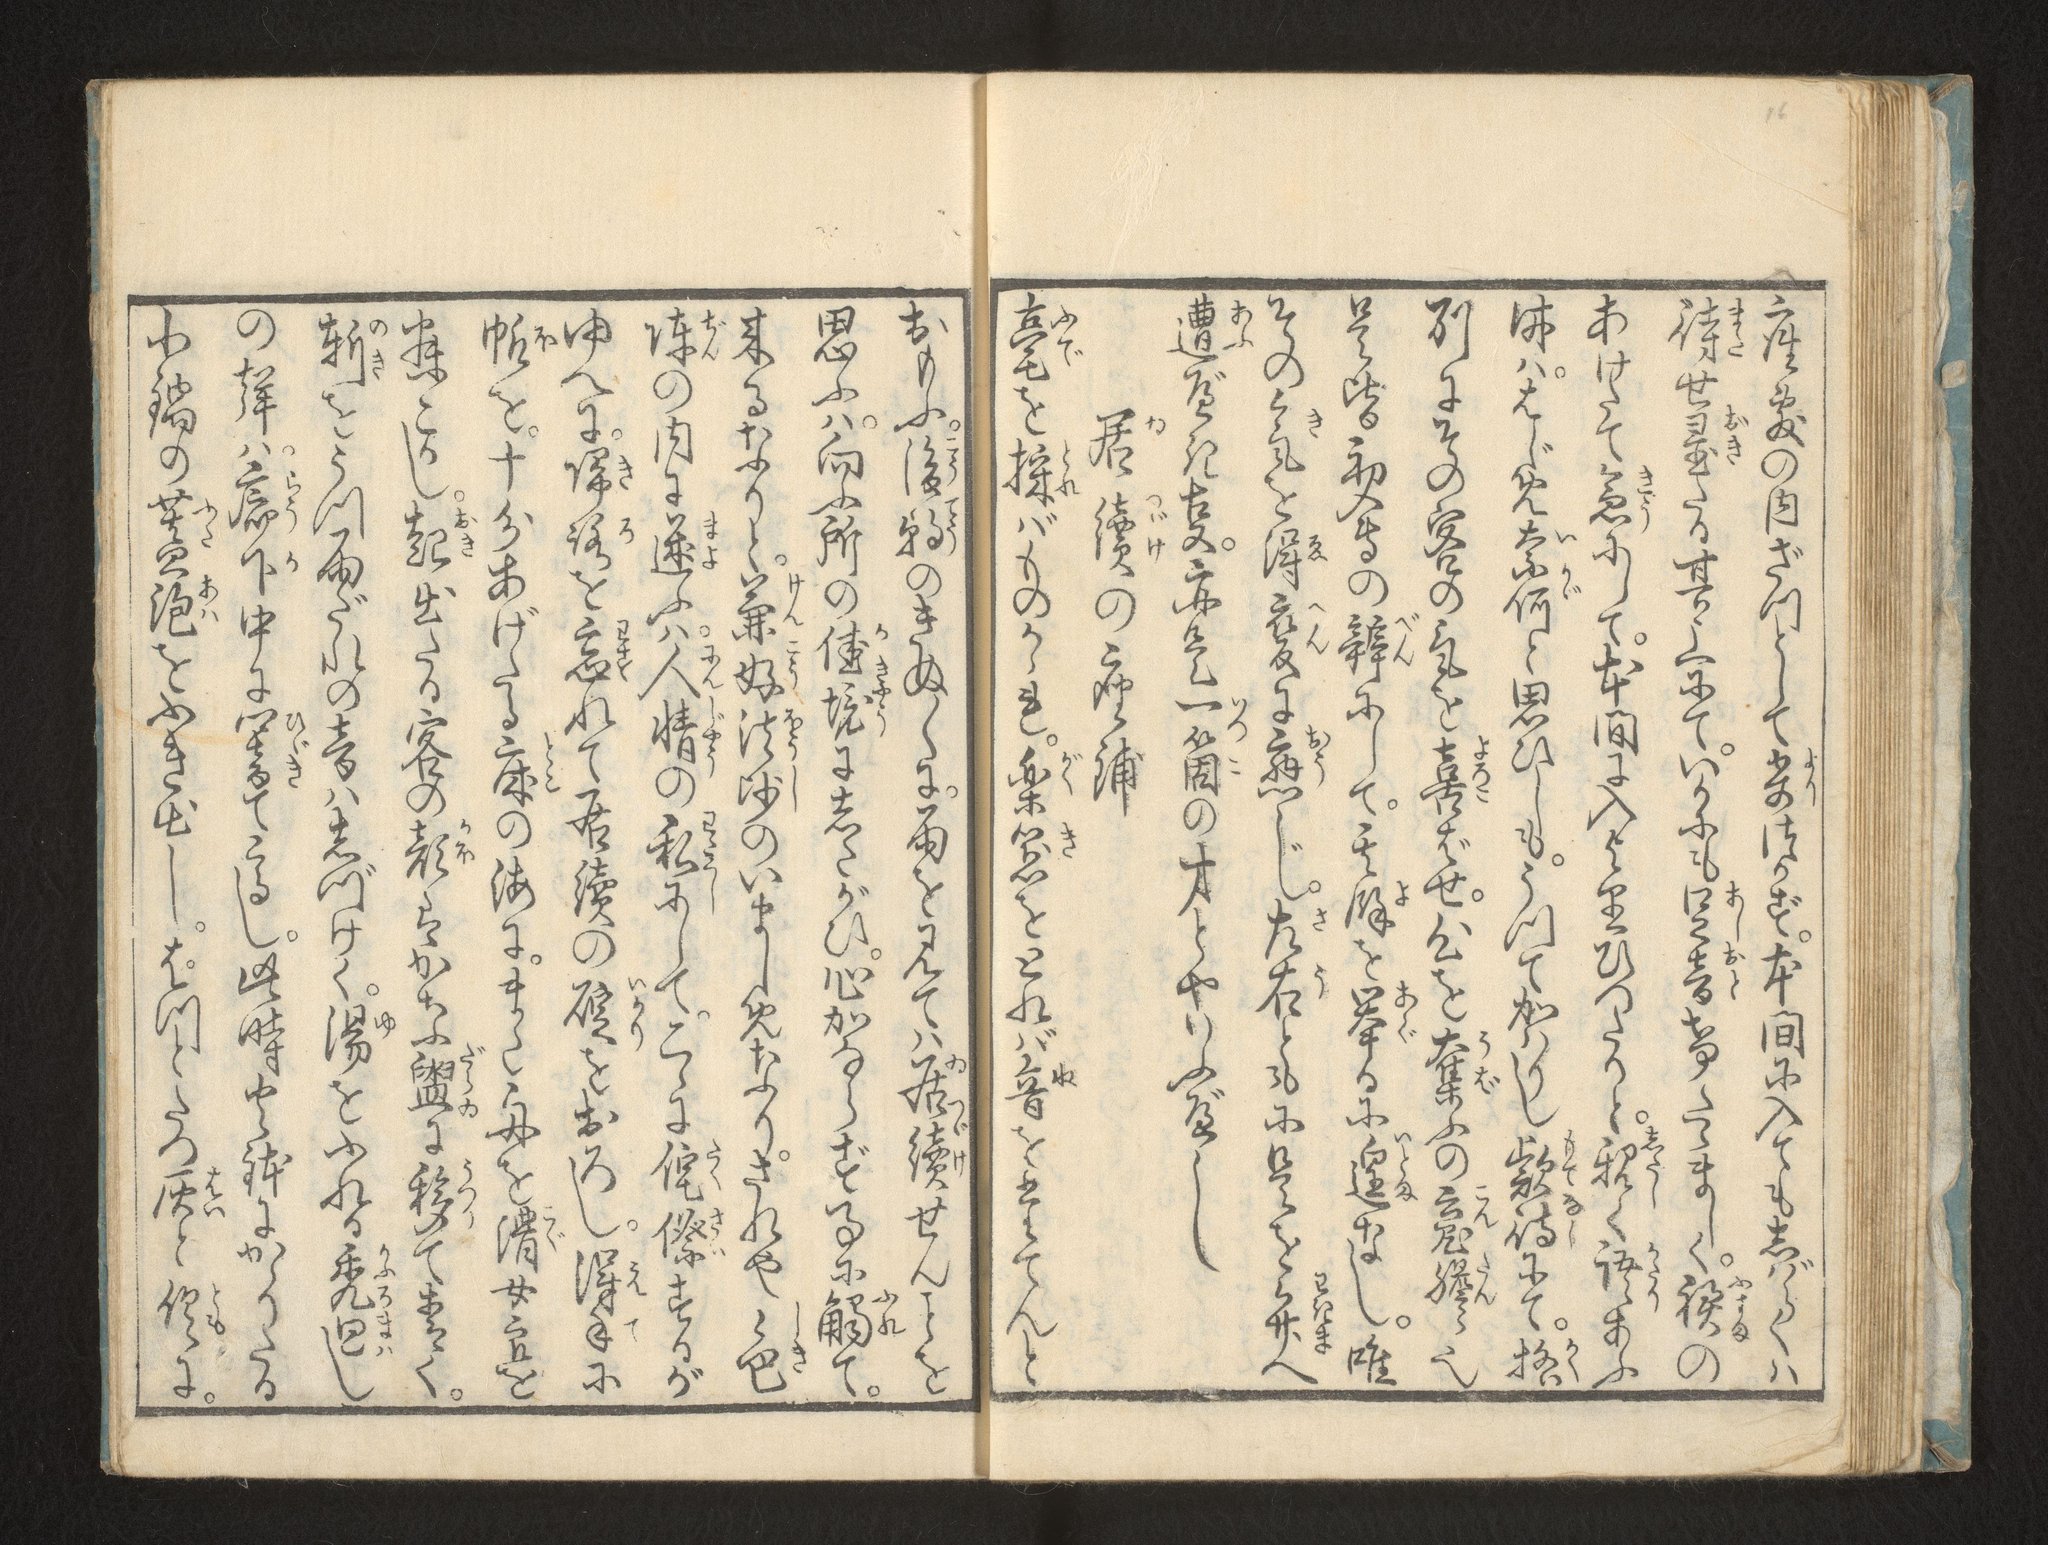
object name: page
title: Tekst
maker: jippensha ikku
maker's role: schrijver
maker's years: 1765-1831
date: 1804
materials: paper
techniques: woodcut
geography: edo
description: Elfde en twaalfde tekstpagina van deel twee van Utamaro`s boek: Gebeurtenissen in de lusthuizen gedurende het jaar.